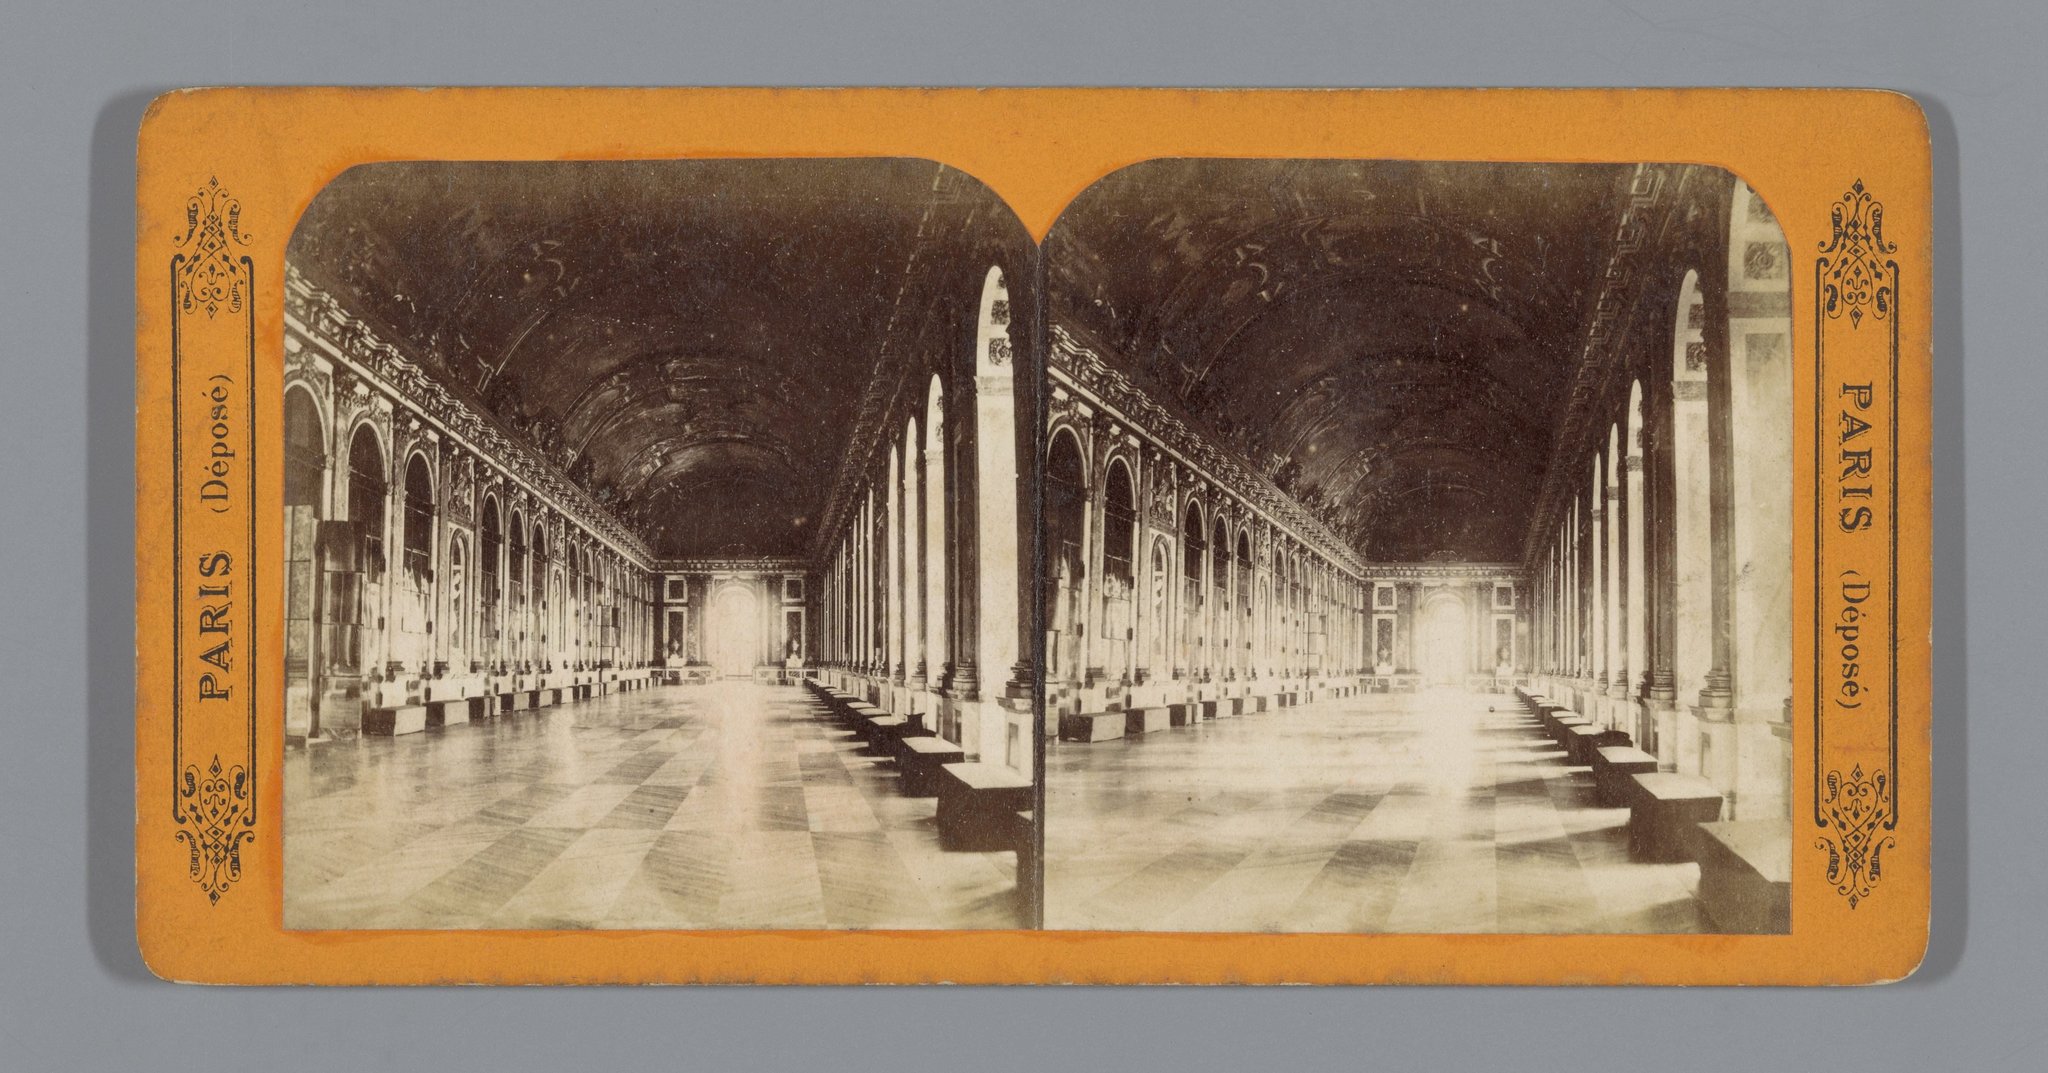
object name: stereograph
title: Spiegelzaal in het Paleis van Versailles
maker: Anonymous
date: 1865-1890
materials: cardboard, photographic support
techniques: albumen print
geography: spiegelzaal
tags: mirror, gallery (spacious corridor)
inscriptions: inscription: ‘Galerie des glaces, Versailles’